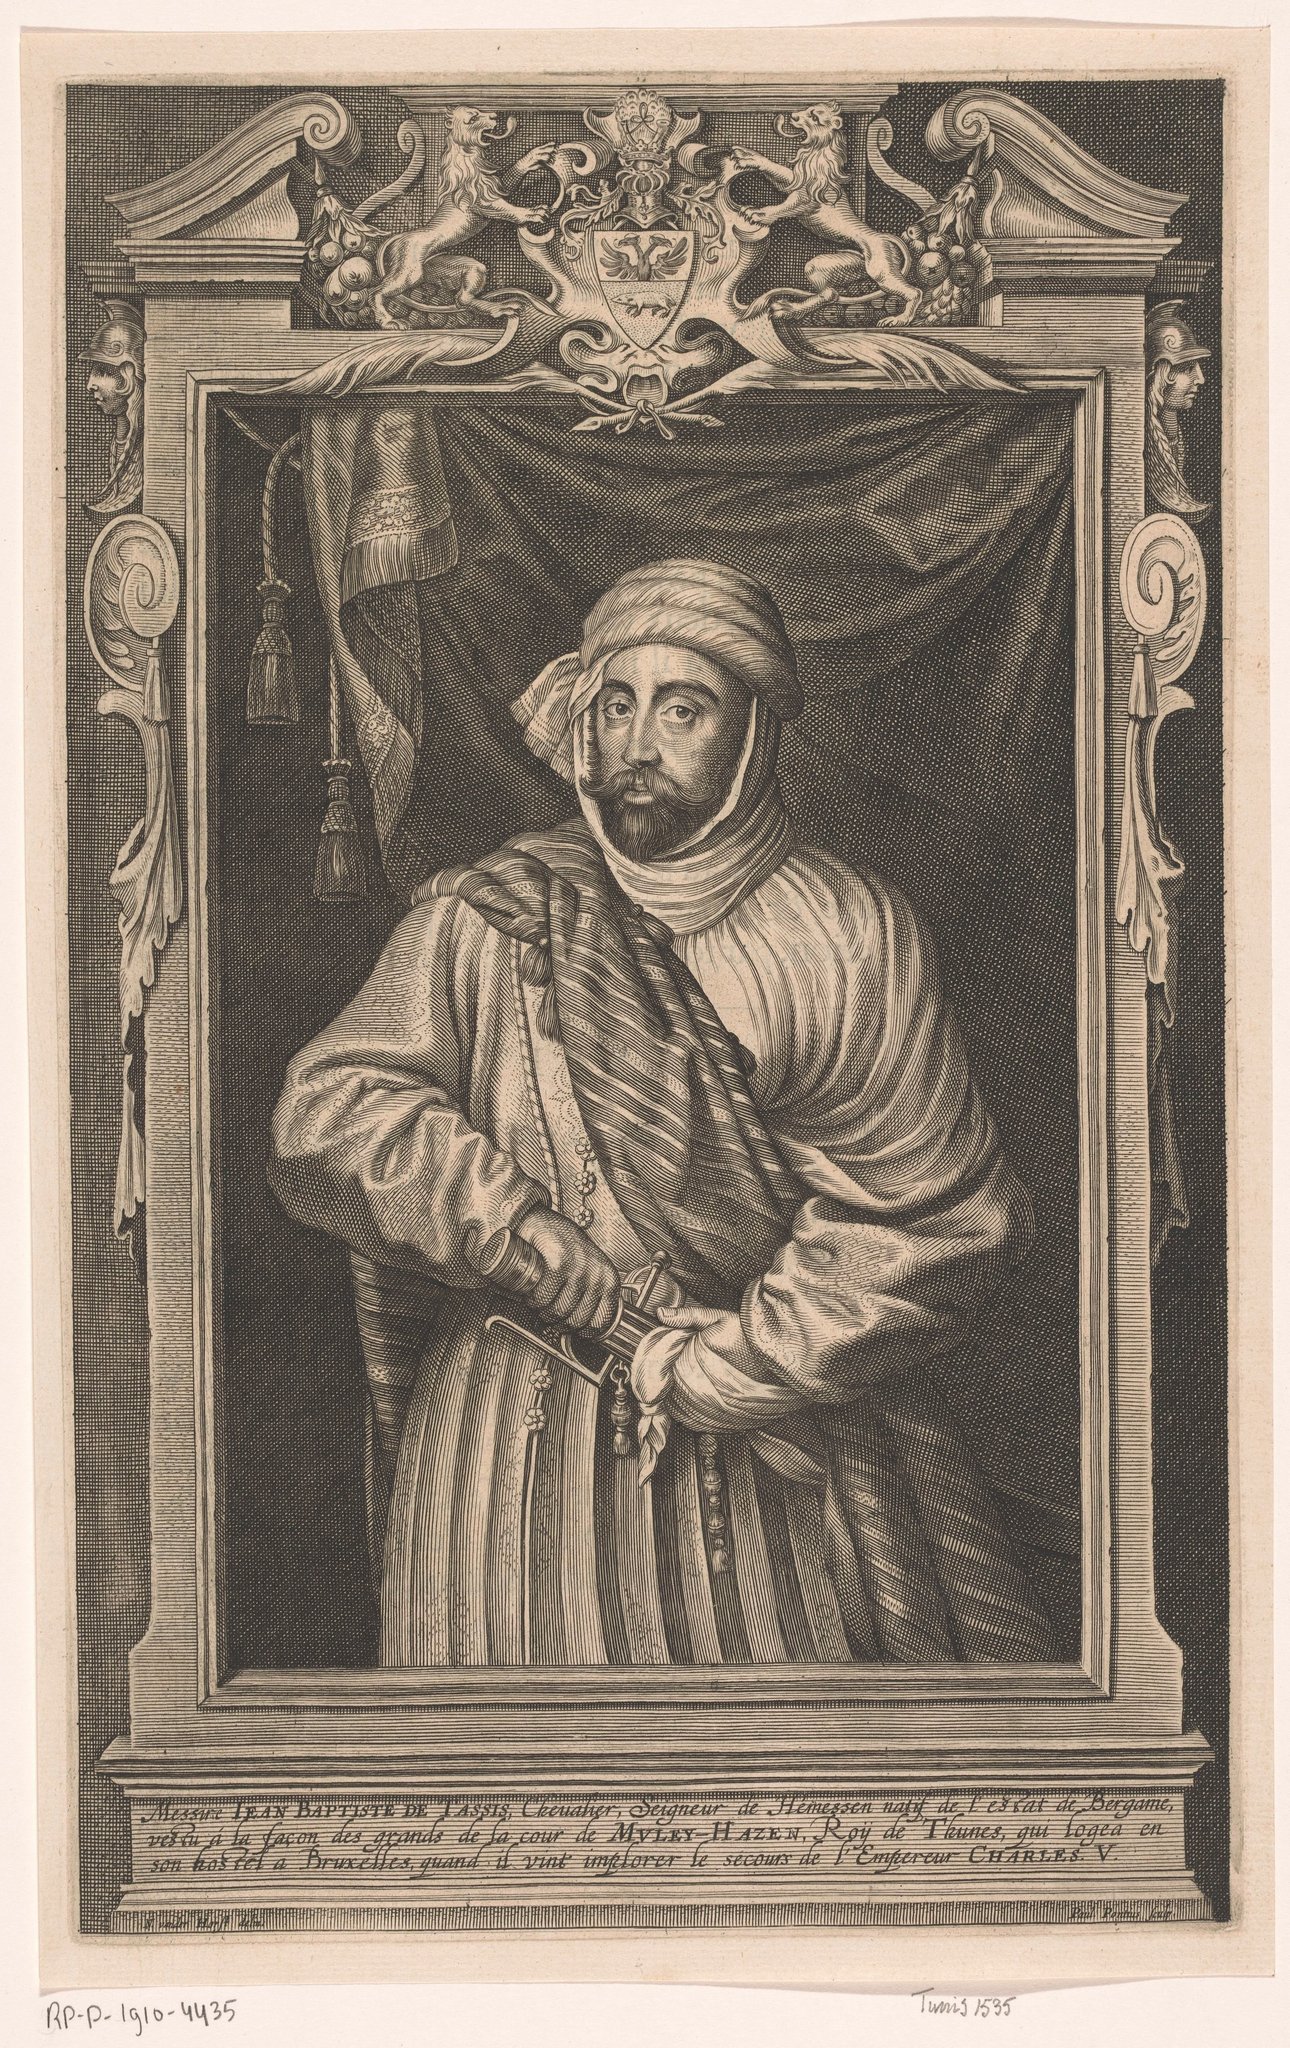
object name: print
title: Portret van Jean Baptiste de Tassis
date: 1645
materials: paper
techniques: engraving, letterpress printing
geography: antwerp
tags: armorial bearing, heraldry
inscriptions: collector's mark: Lugt 2228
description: Portret van Giovanni Battista de Tassis, postmeester en werkzaam aan het hof van Karel V. Het portret is gevat in een ornamentele omlijsting die is bekroond met zijn wapenschild. Onderaan de omlijsting een drieregelige biografie in het Frans.